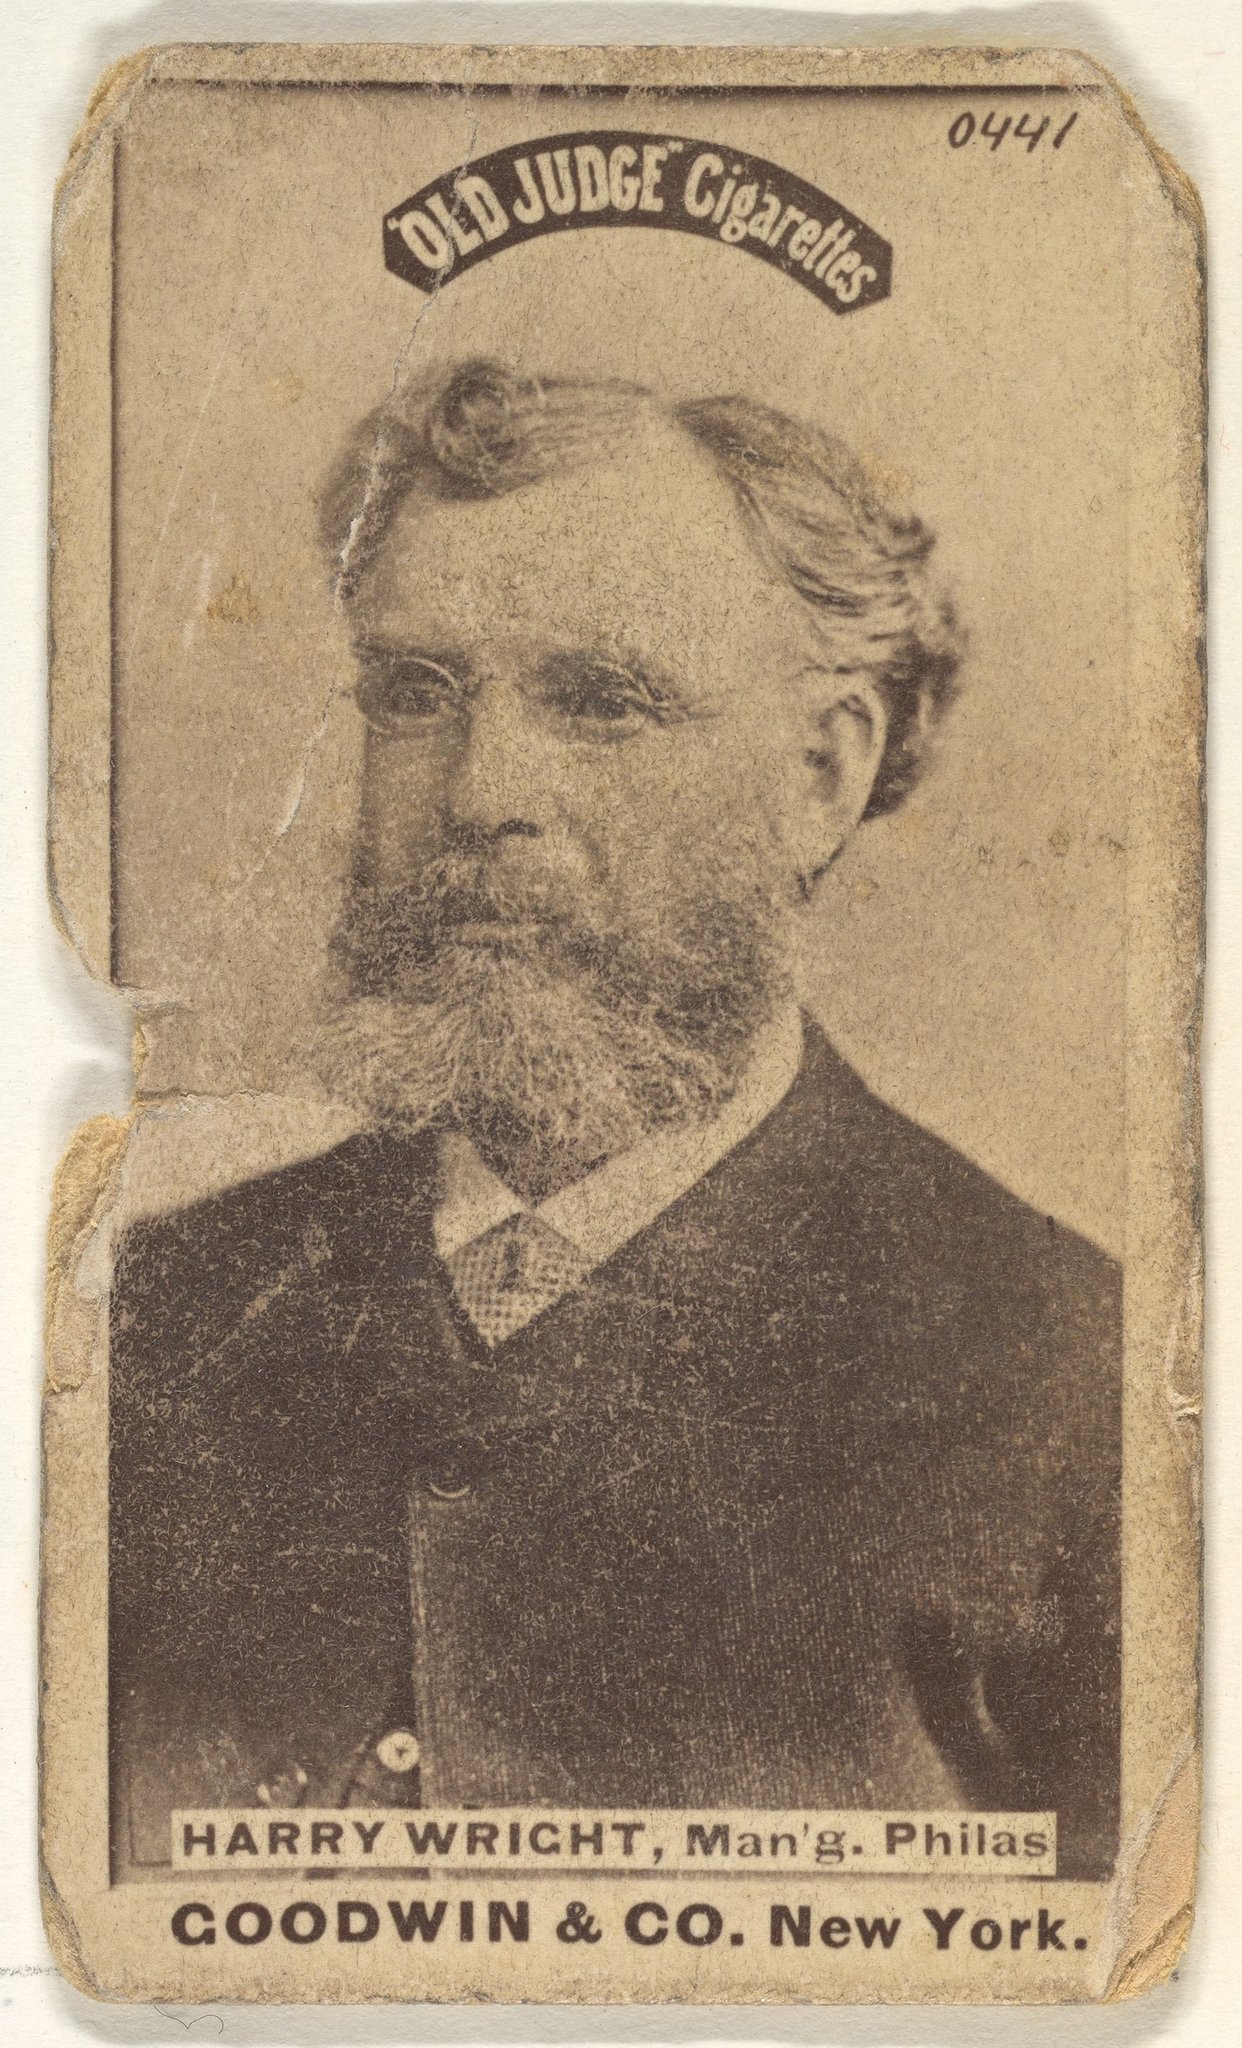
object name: baseball card, photograph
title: William Henry "Harry" Wright, Manager, Philadelphia, from the Old Judge series (N172) for Old Judge Cigarettes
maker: goodwin & company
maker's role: publisher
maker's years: 1850-1950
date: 1887-1890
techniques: albumen silver print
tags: men,portraits,baseball,athletes